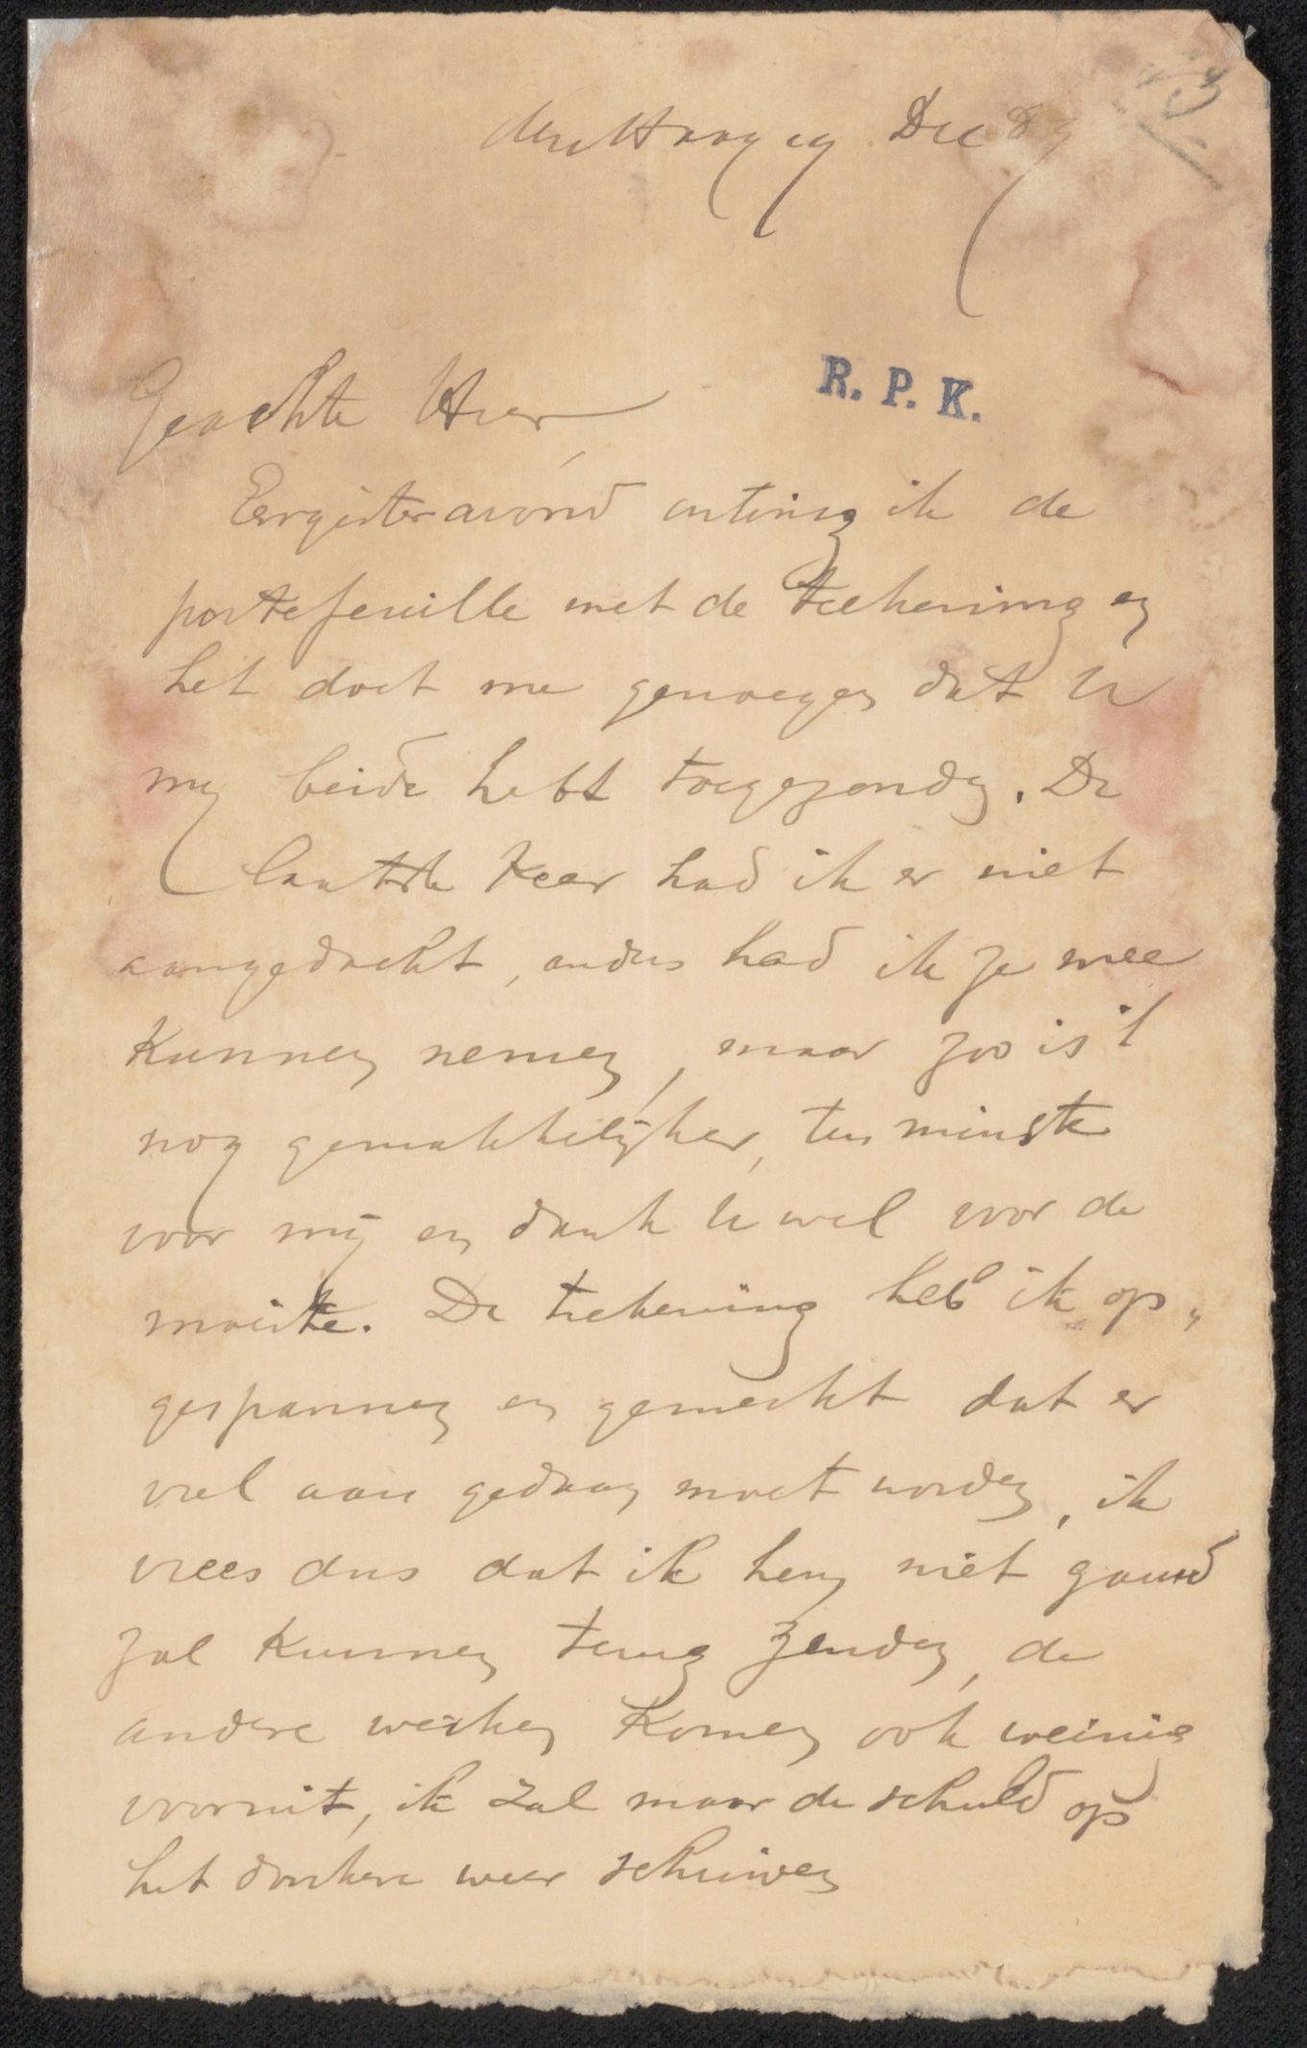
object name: letter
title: Brief aan Frans Buffa en Zonen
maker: willem bastiaan tholen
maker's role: draughtsman, painter, print maker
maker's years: 1860-1931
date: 1889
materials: ink, paper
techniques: pen, writing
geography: the hague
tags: publisher, drawing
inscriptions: collector's mark: Lugt 2233, watermark